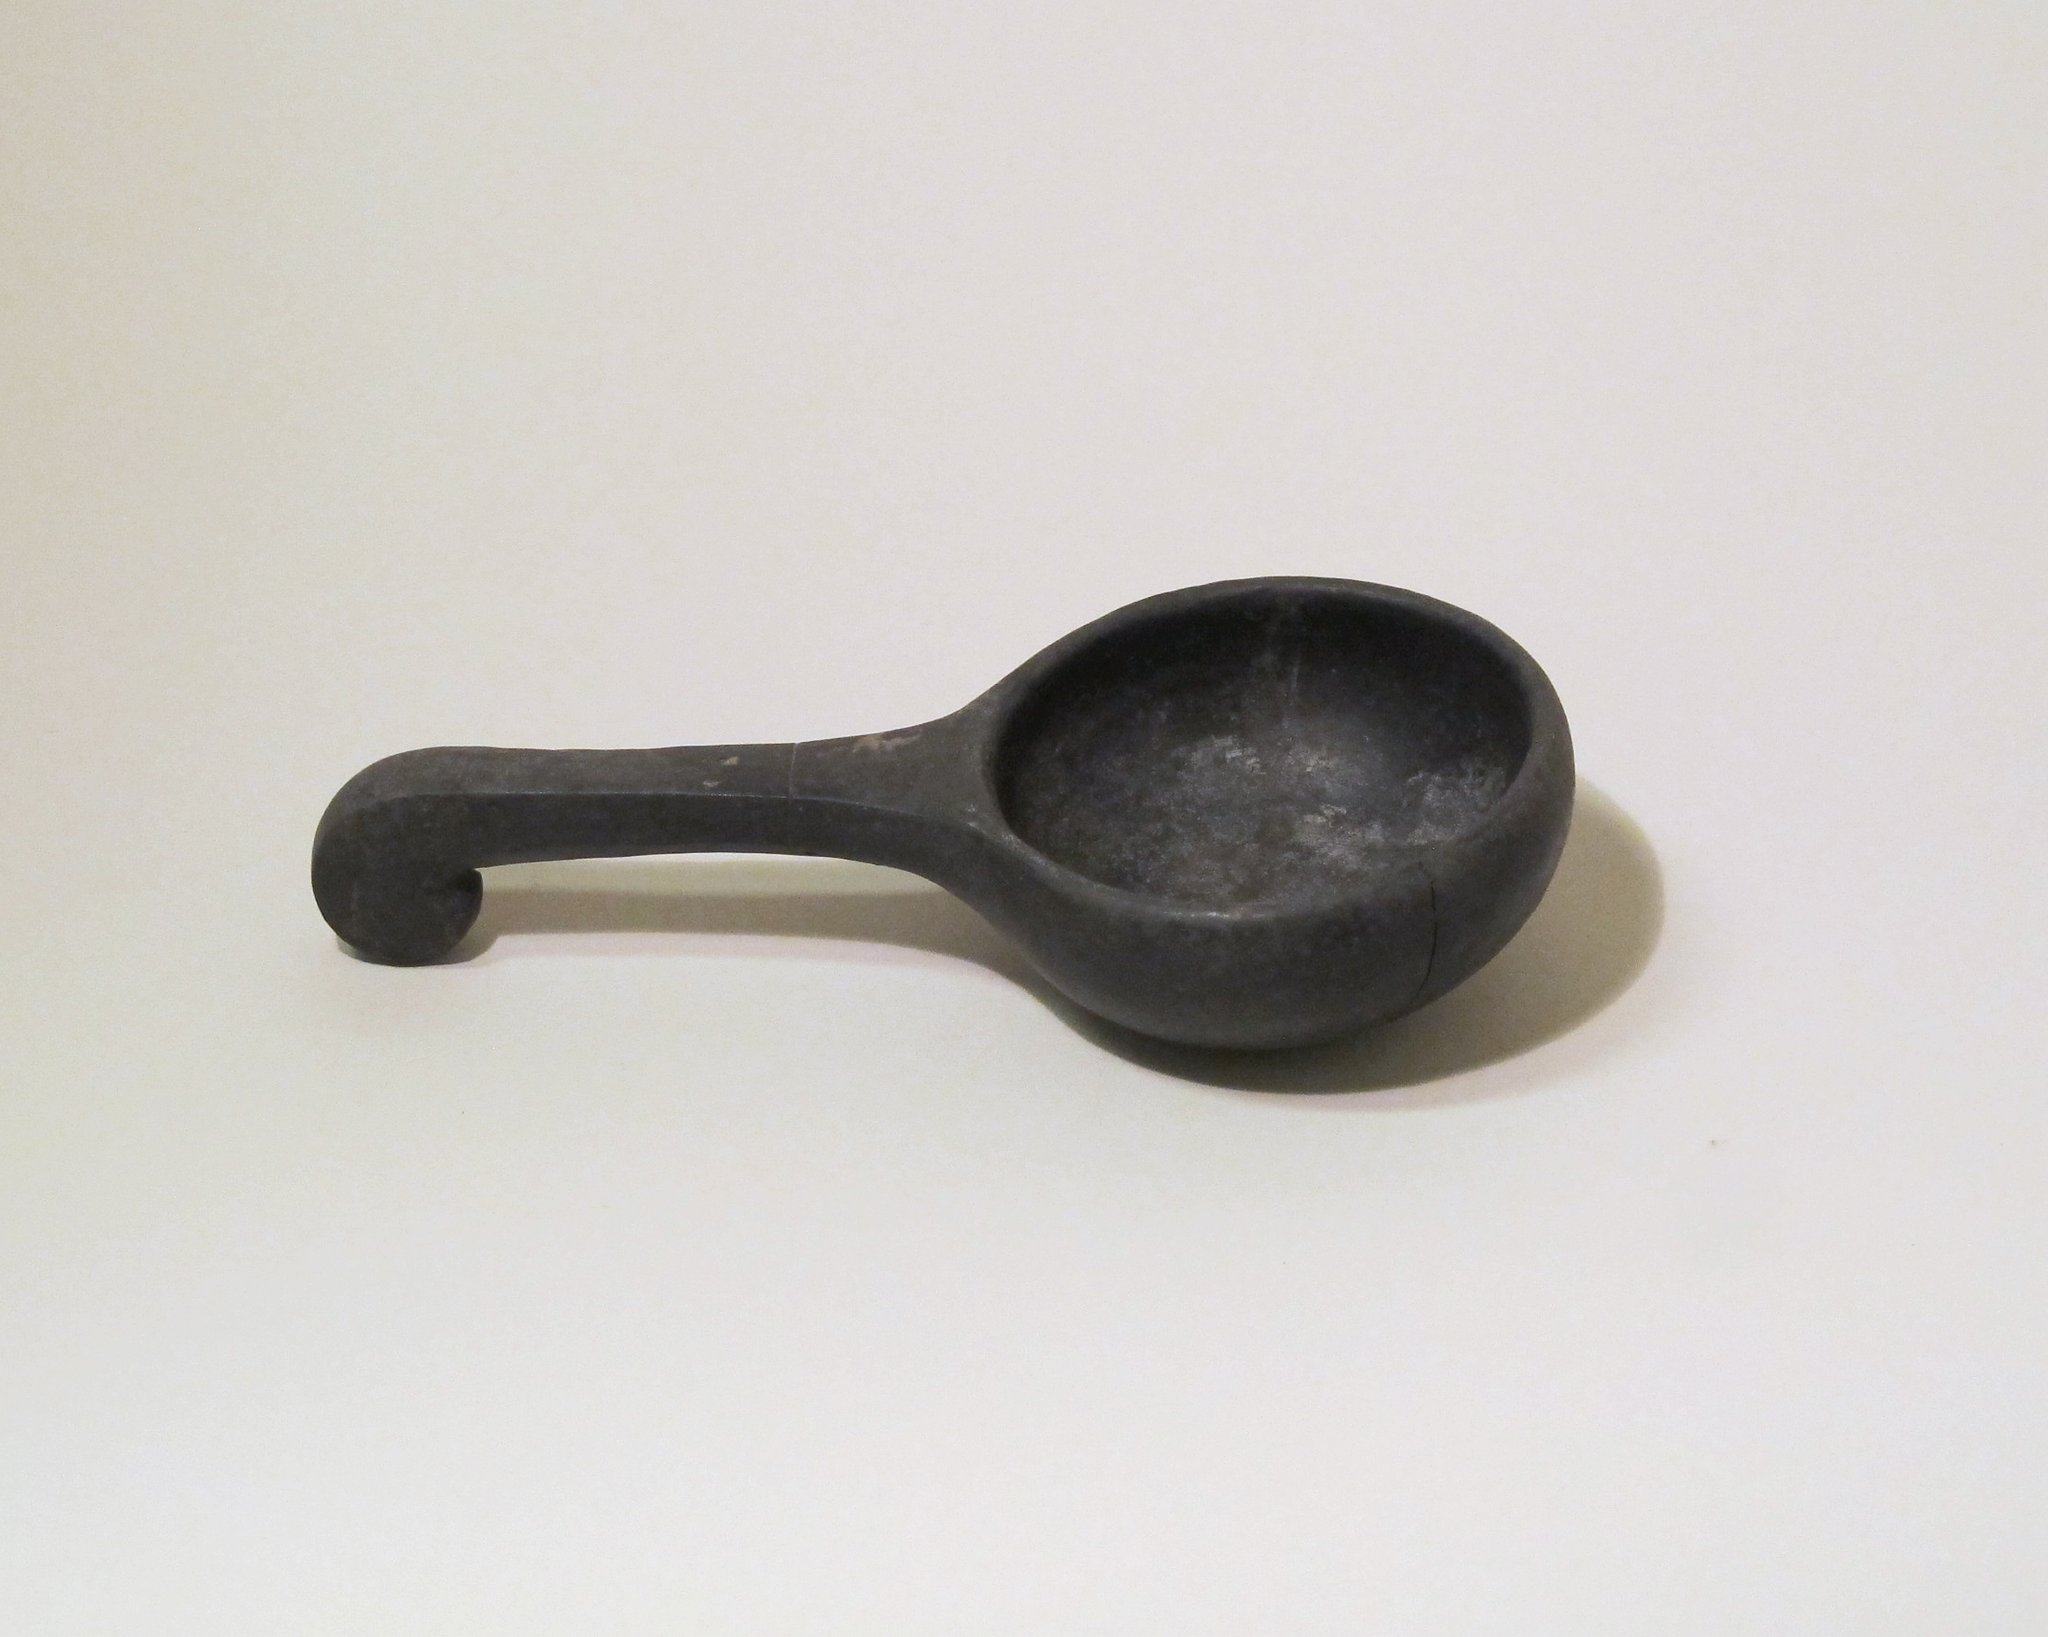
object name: focolare spoon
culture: etruscan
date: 550-501 BCE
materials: terracotta